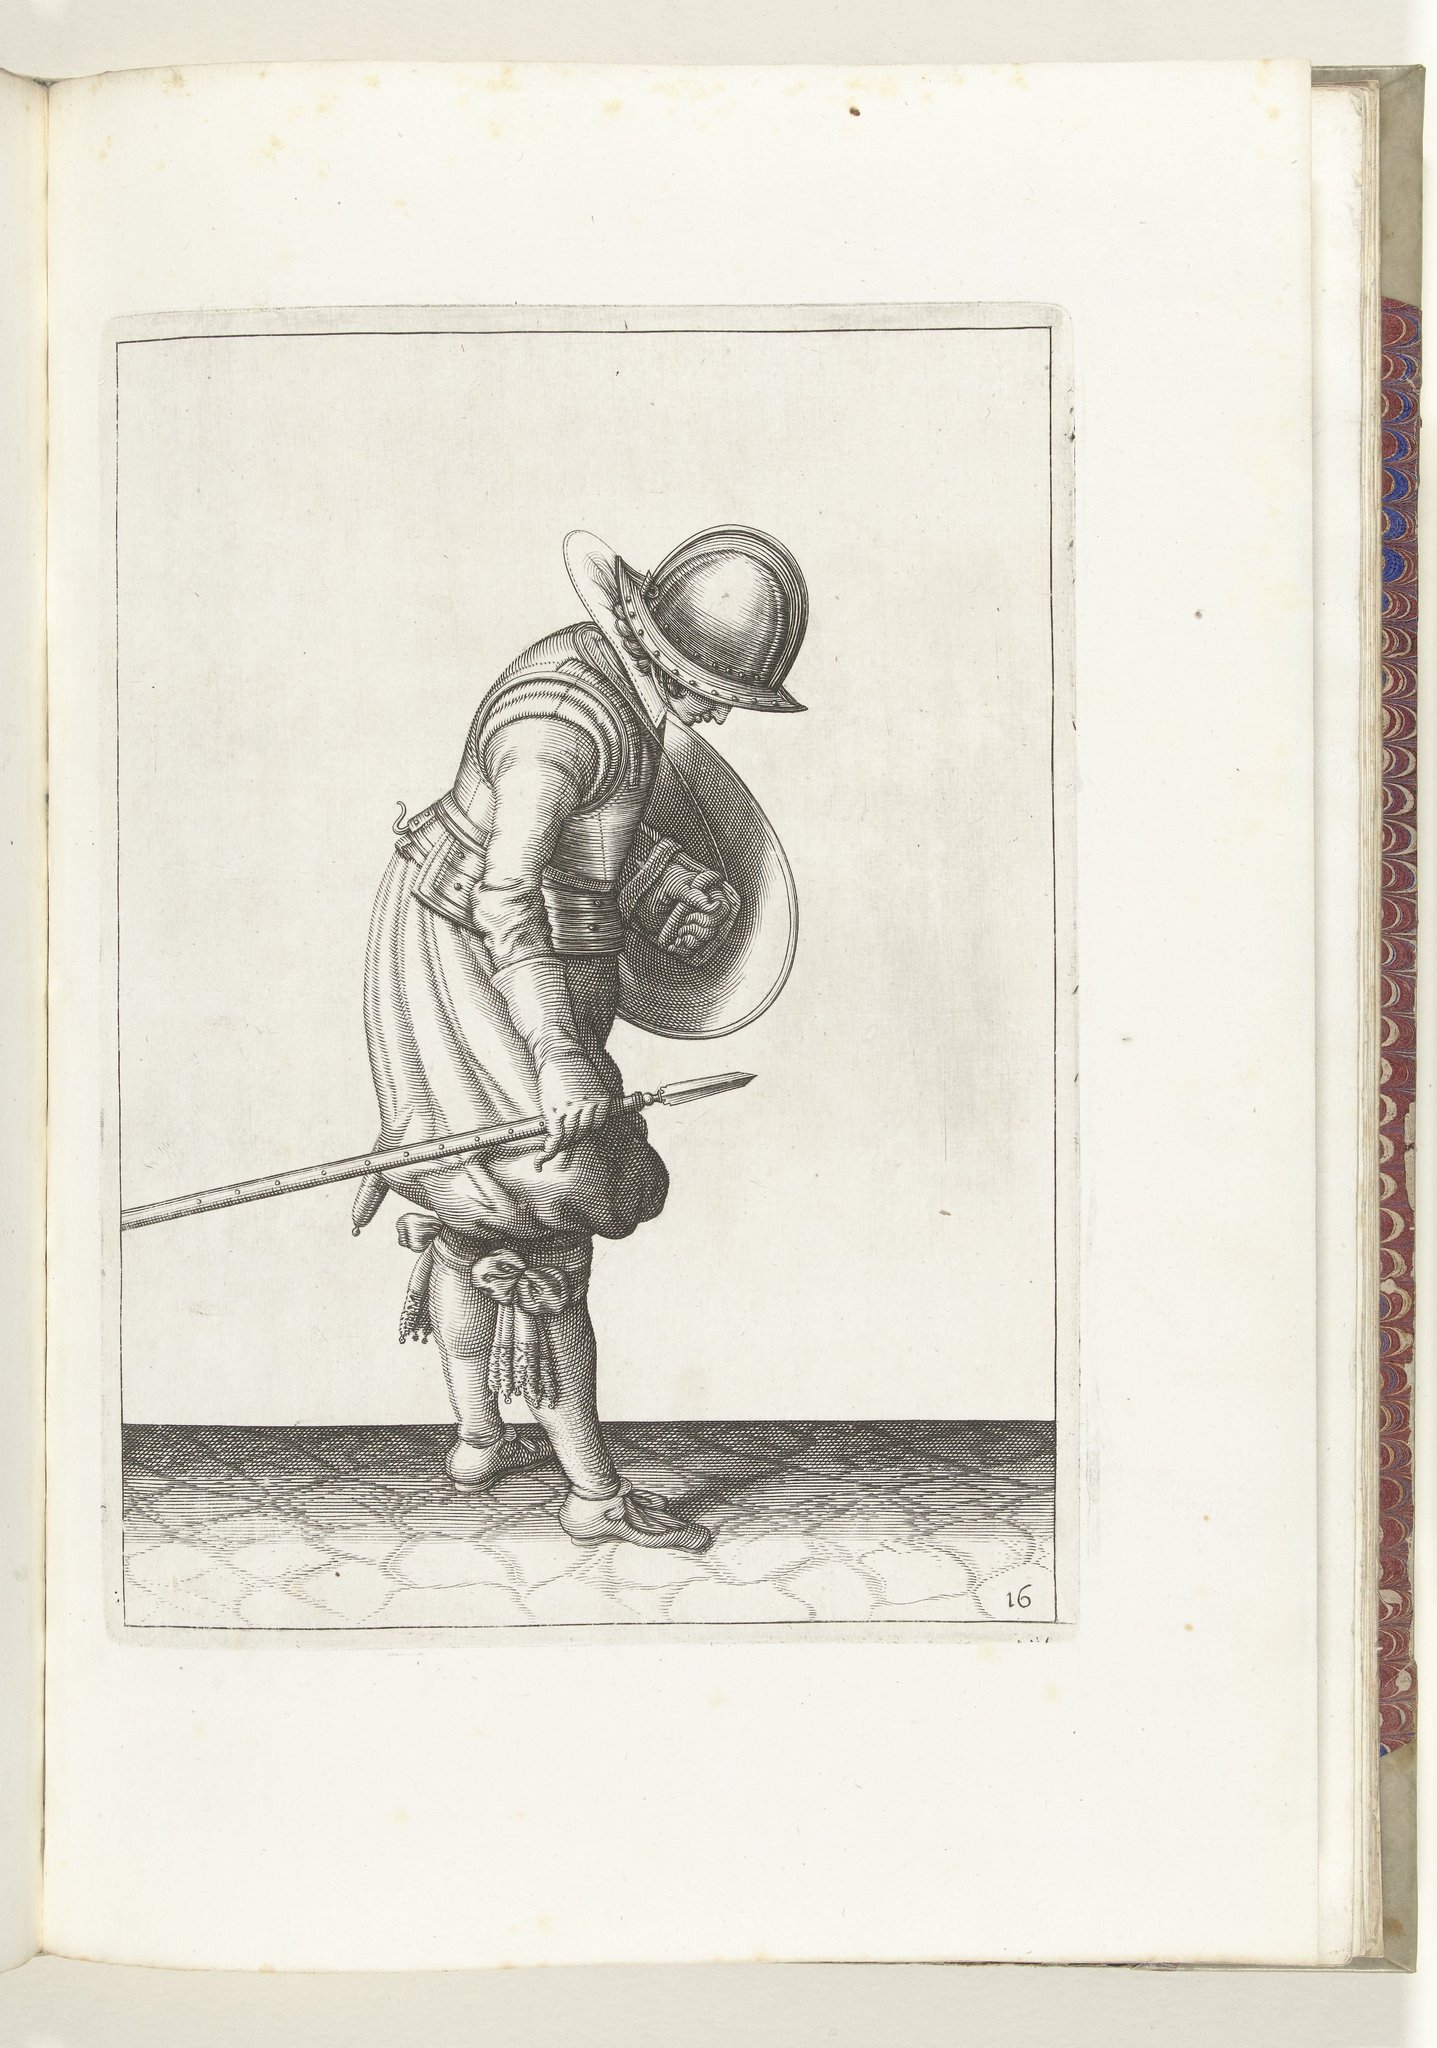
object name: print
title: De exercitie met schild en spies: de soldaat legt de spies naast zijn rechtervoet op de grond (nr. 16), 1618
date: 1616-1618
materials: paper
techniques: engraving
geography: northern netherlands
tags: maurice (prince of orange), handling of weapons ~ military training, weapons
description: Illustratie in: Adam van Breen, De Nassausche Wapen-Handelinge, van Schilt, Spies, Rappier ende Targe : beyde figuerlick afgebeelt, ende gestelt na de nieu ordening [van] ... Maurits van Nassau, 's-Gravenhage, [Aert Meuris] 1618, plaat nr. 16. In het exemplaar in de collectie van de Rijksmuseum Research Library (326 F 22).